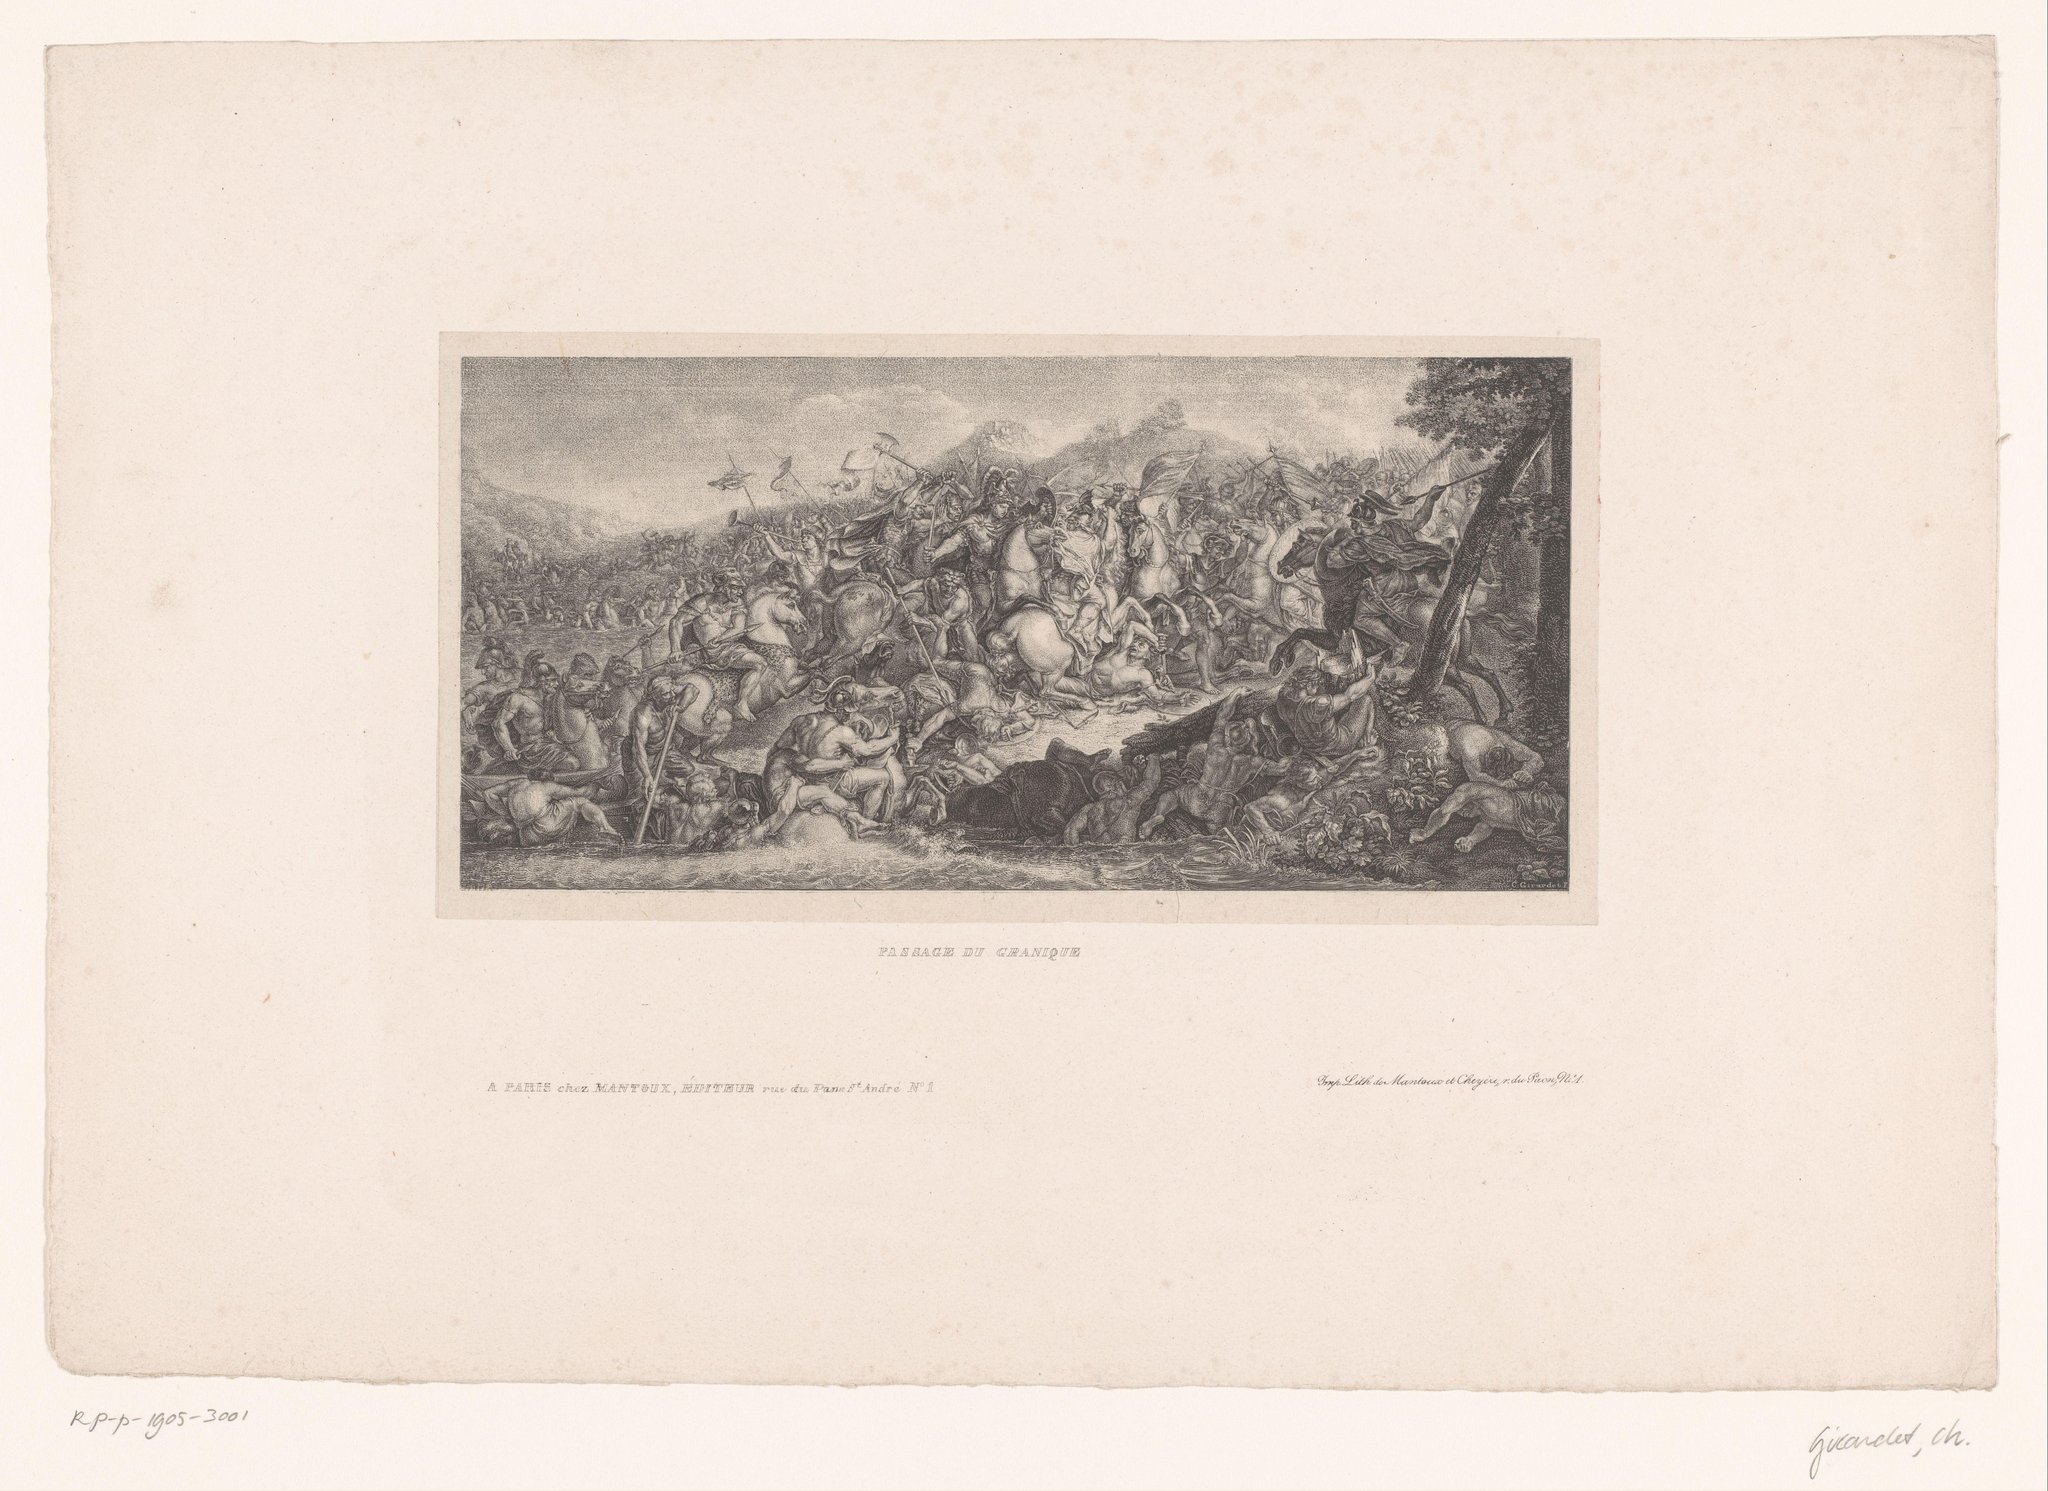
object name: print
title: Passage du Granique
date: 1837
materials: paper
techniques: etching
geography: paris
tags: historical persons, battle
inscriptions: collector's mark: Lugt 2228a